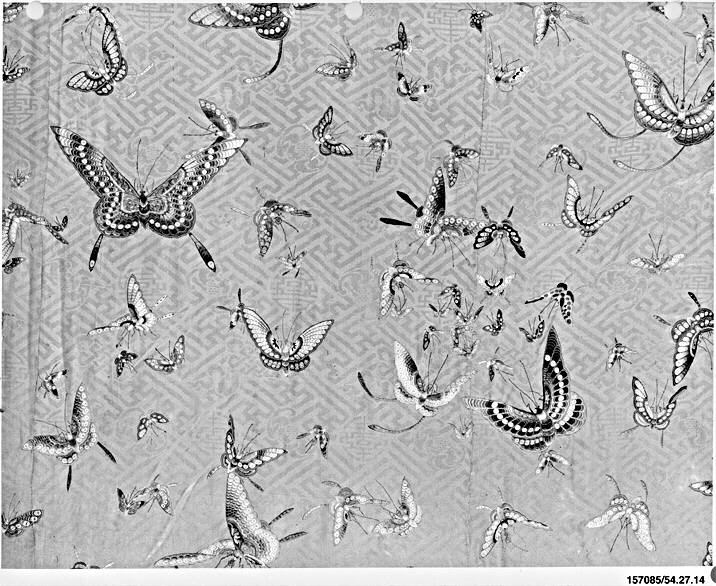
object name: hanging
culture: chinese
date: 1867-1900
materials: silk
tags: insects,butterflies